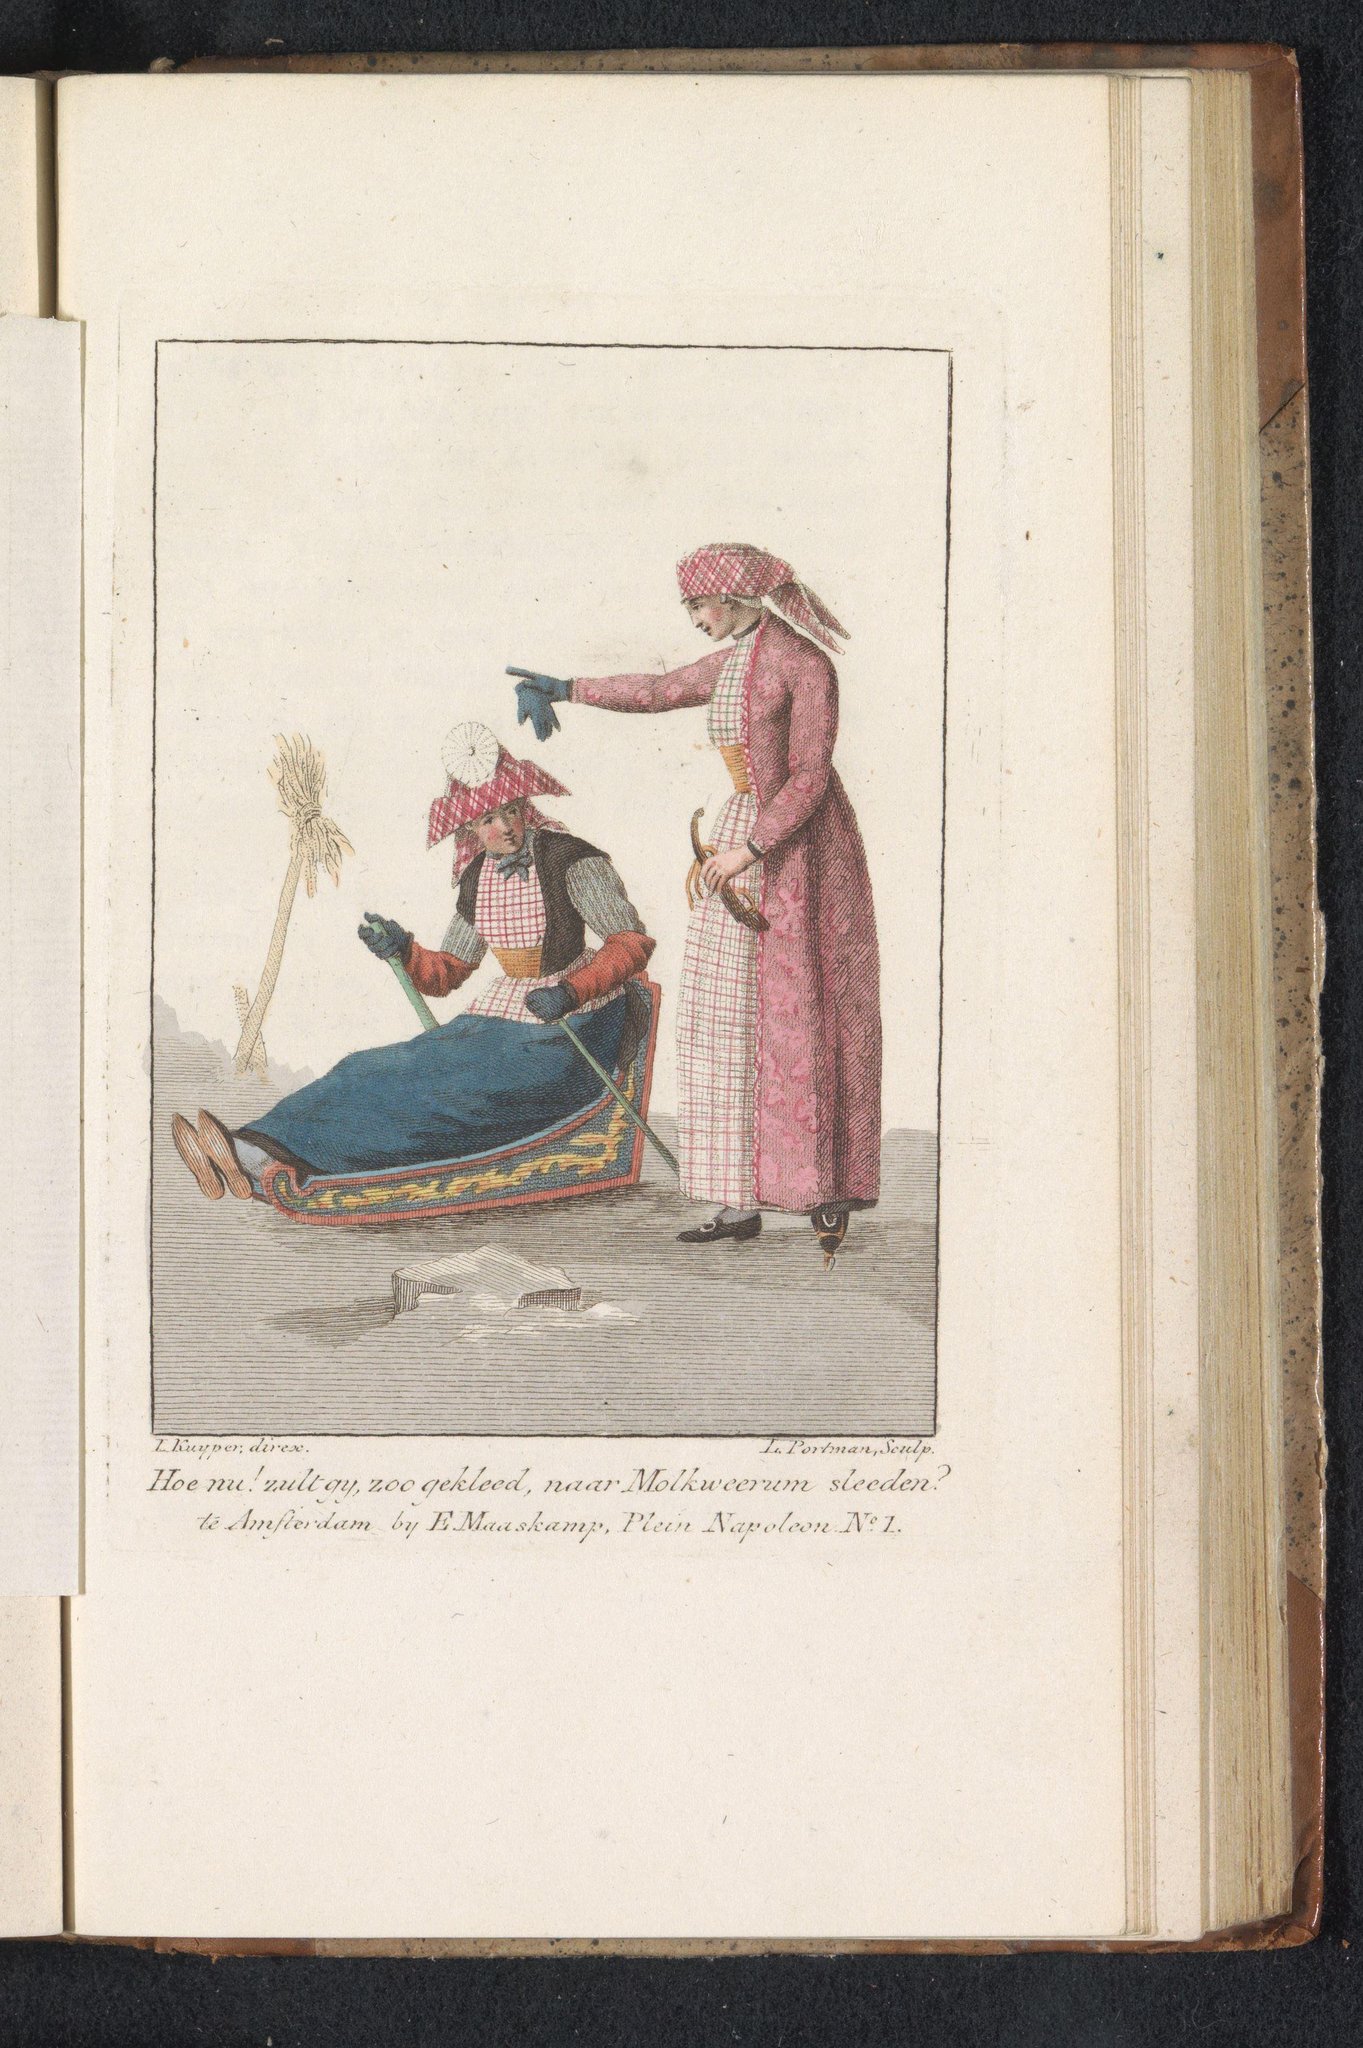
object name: print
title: Hoe nu! zult gij, zoo gekleed, naar Molkweerum sleeden?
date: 1812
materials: paper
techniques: etching, hand coloring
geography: amsterdam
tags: skates (winter sports), folk costume, regional costume, clothes, costume, small sleigh (winter sports)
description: Twee jongedames in Friese klederdracht op het ijs. De een zit in een slee, de andere staat op de schaats. Uit Hindeloopen of een plaats in de buurt. Onderdeel van de verkleinde kopieën uit 1812 naar de platen van Nederlandse klederdrachten uit de jaren 1803-1807.